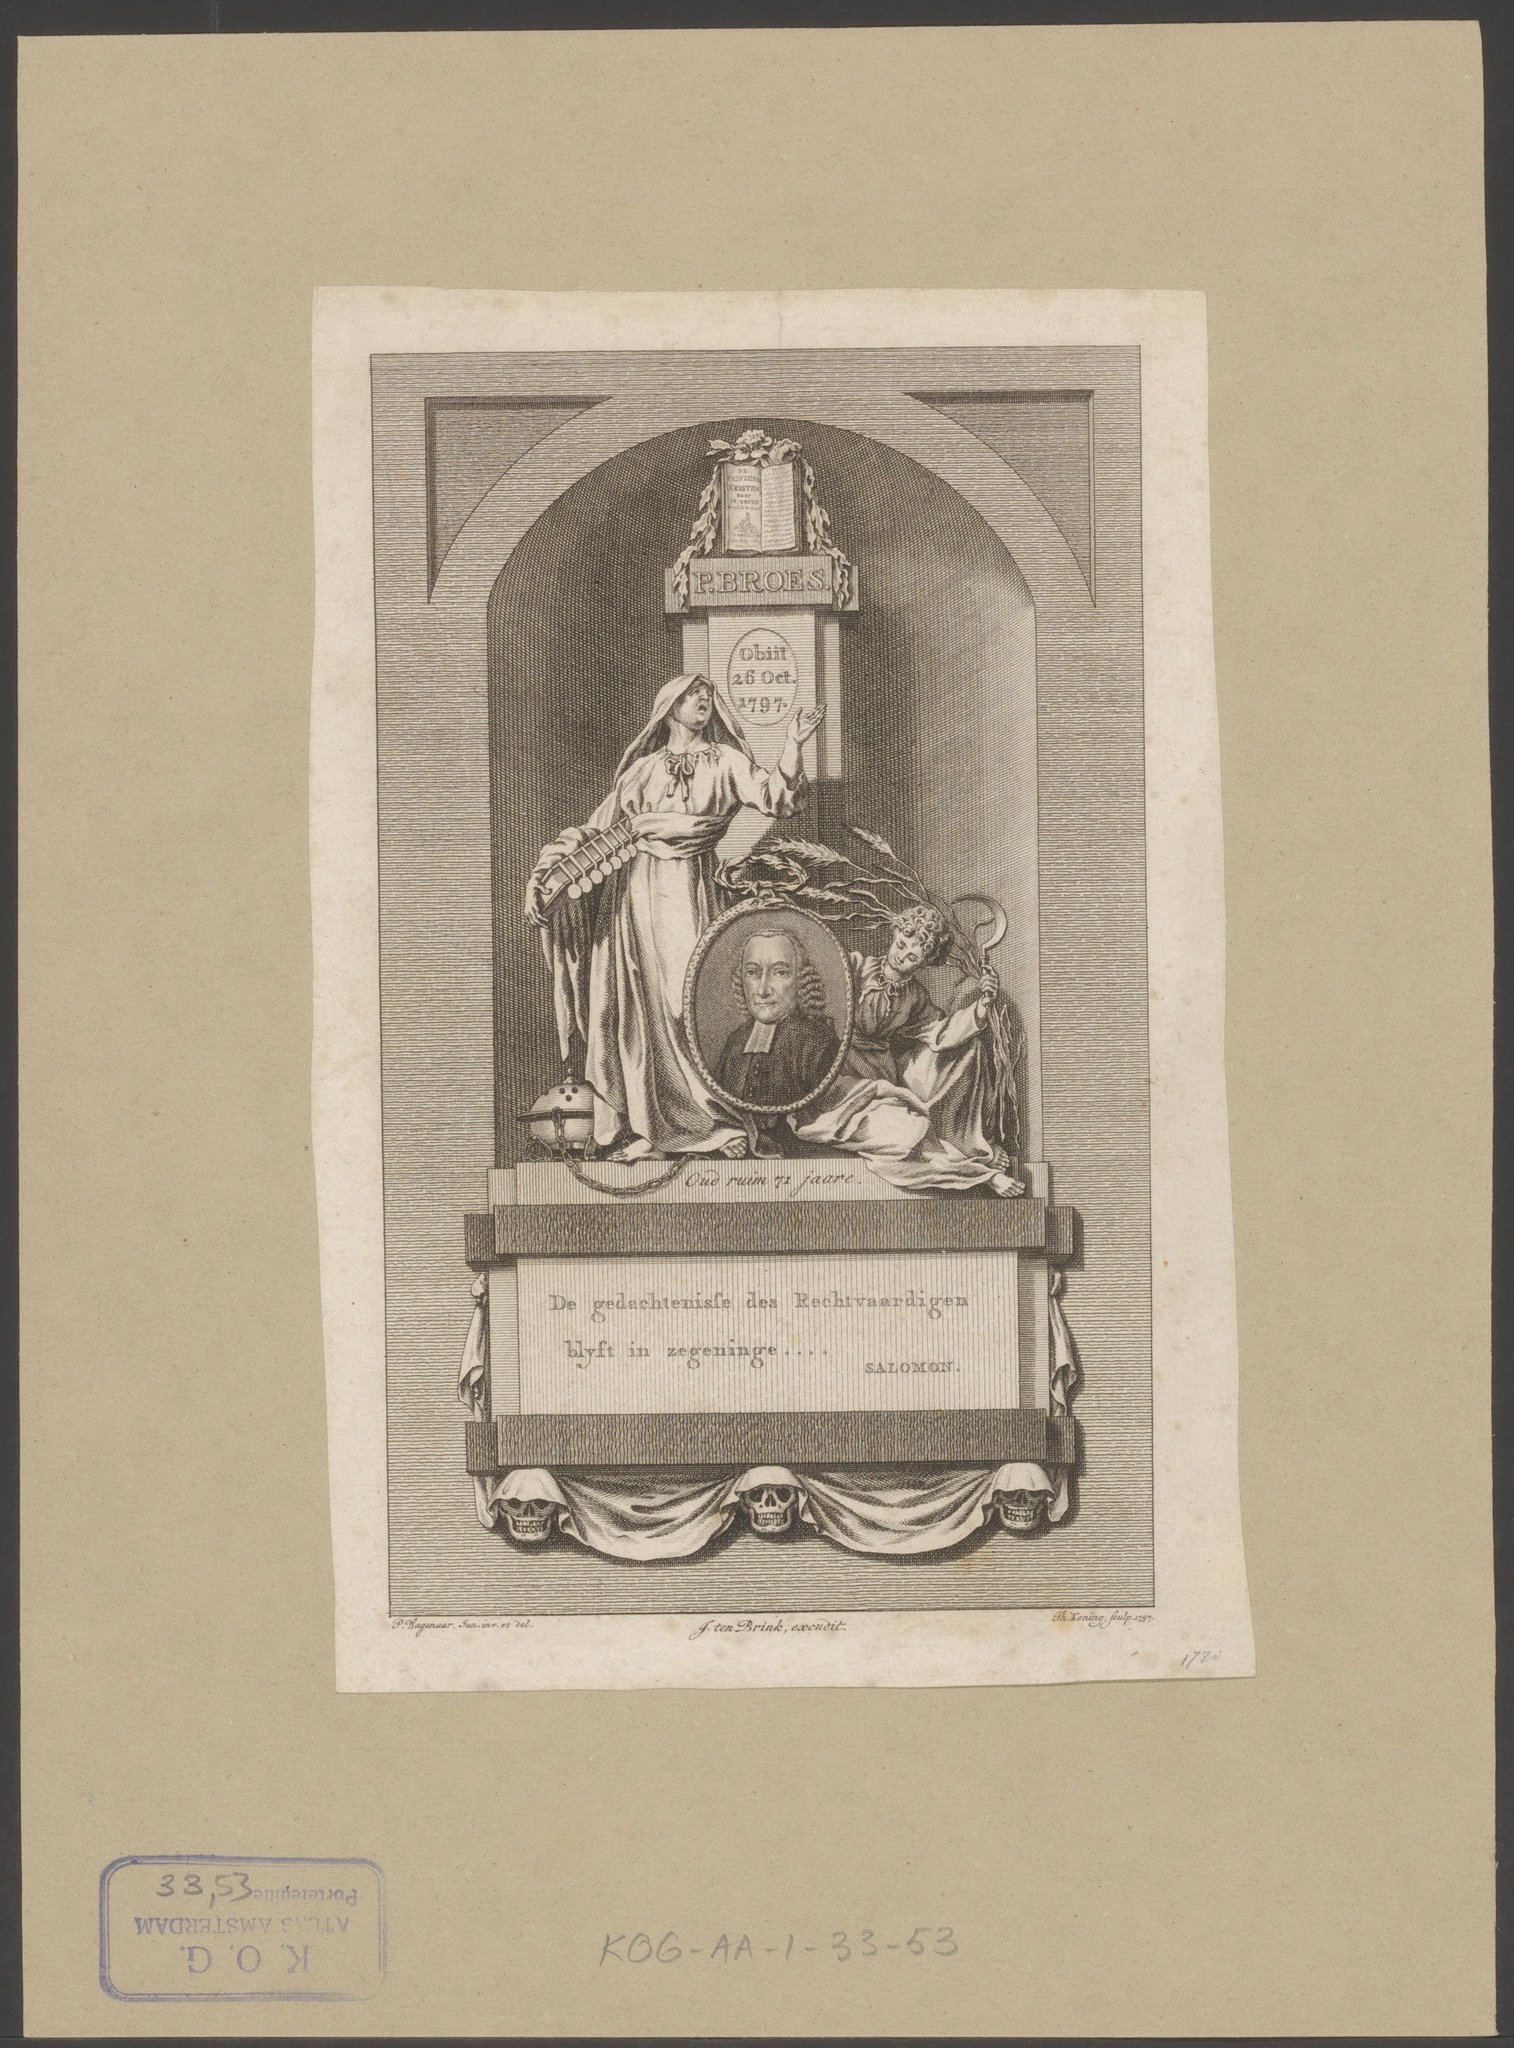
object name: print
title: Allegorisch grafmonument voor Petrus Broes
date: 1797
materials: paper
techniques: engraving, etching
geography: amsterdam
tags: historical persons, serpent ouroboros, other allegories of time, e.g. 'tempo' (ripa), grave-building, monumental tomb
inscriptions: collector's mark: Lugt 1641b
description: Allegorisch grafmonument voor de predikant Petrus Broes. Rechts de personificatie van Tijd, met korenaren en een sikkel, die een einde aan het leven maakt. Links een jammerende vrouw met een boek met zeven zegels onder de arm. Zij flankeren het ovale busteportret van Broes, dat wordt omlijst door de Ouroboros: een slang die in zijn eigen staart bijt, het teken van eeuwigheid. Achter het portret een zuil met daarop een met bloemen versierd boek. Onder het monument drie schedels. Onderwerpsrubriek binnen de Atlas Amsterdam: Kerkwezen: Hervormde Gemeente: Herinneringen aan hervormde predikanten.